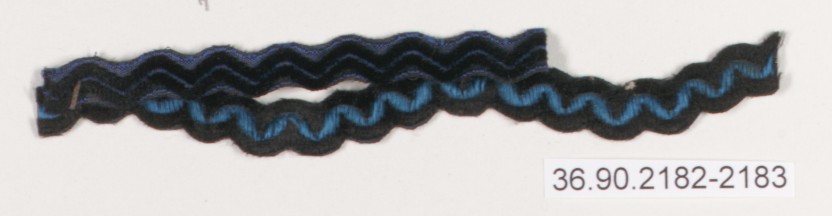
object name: piece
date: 1801-1900